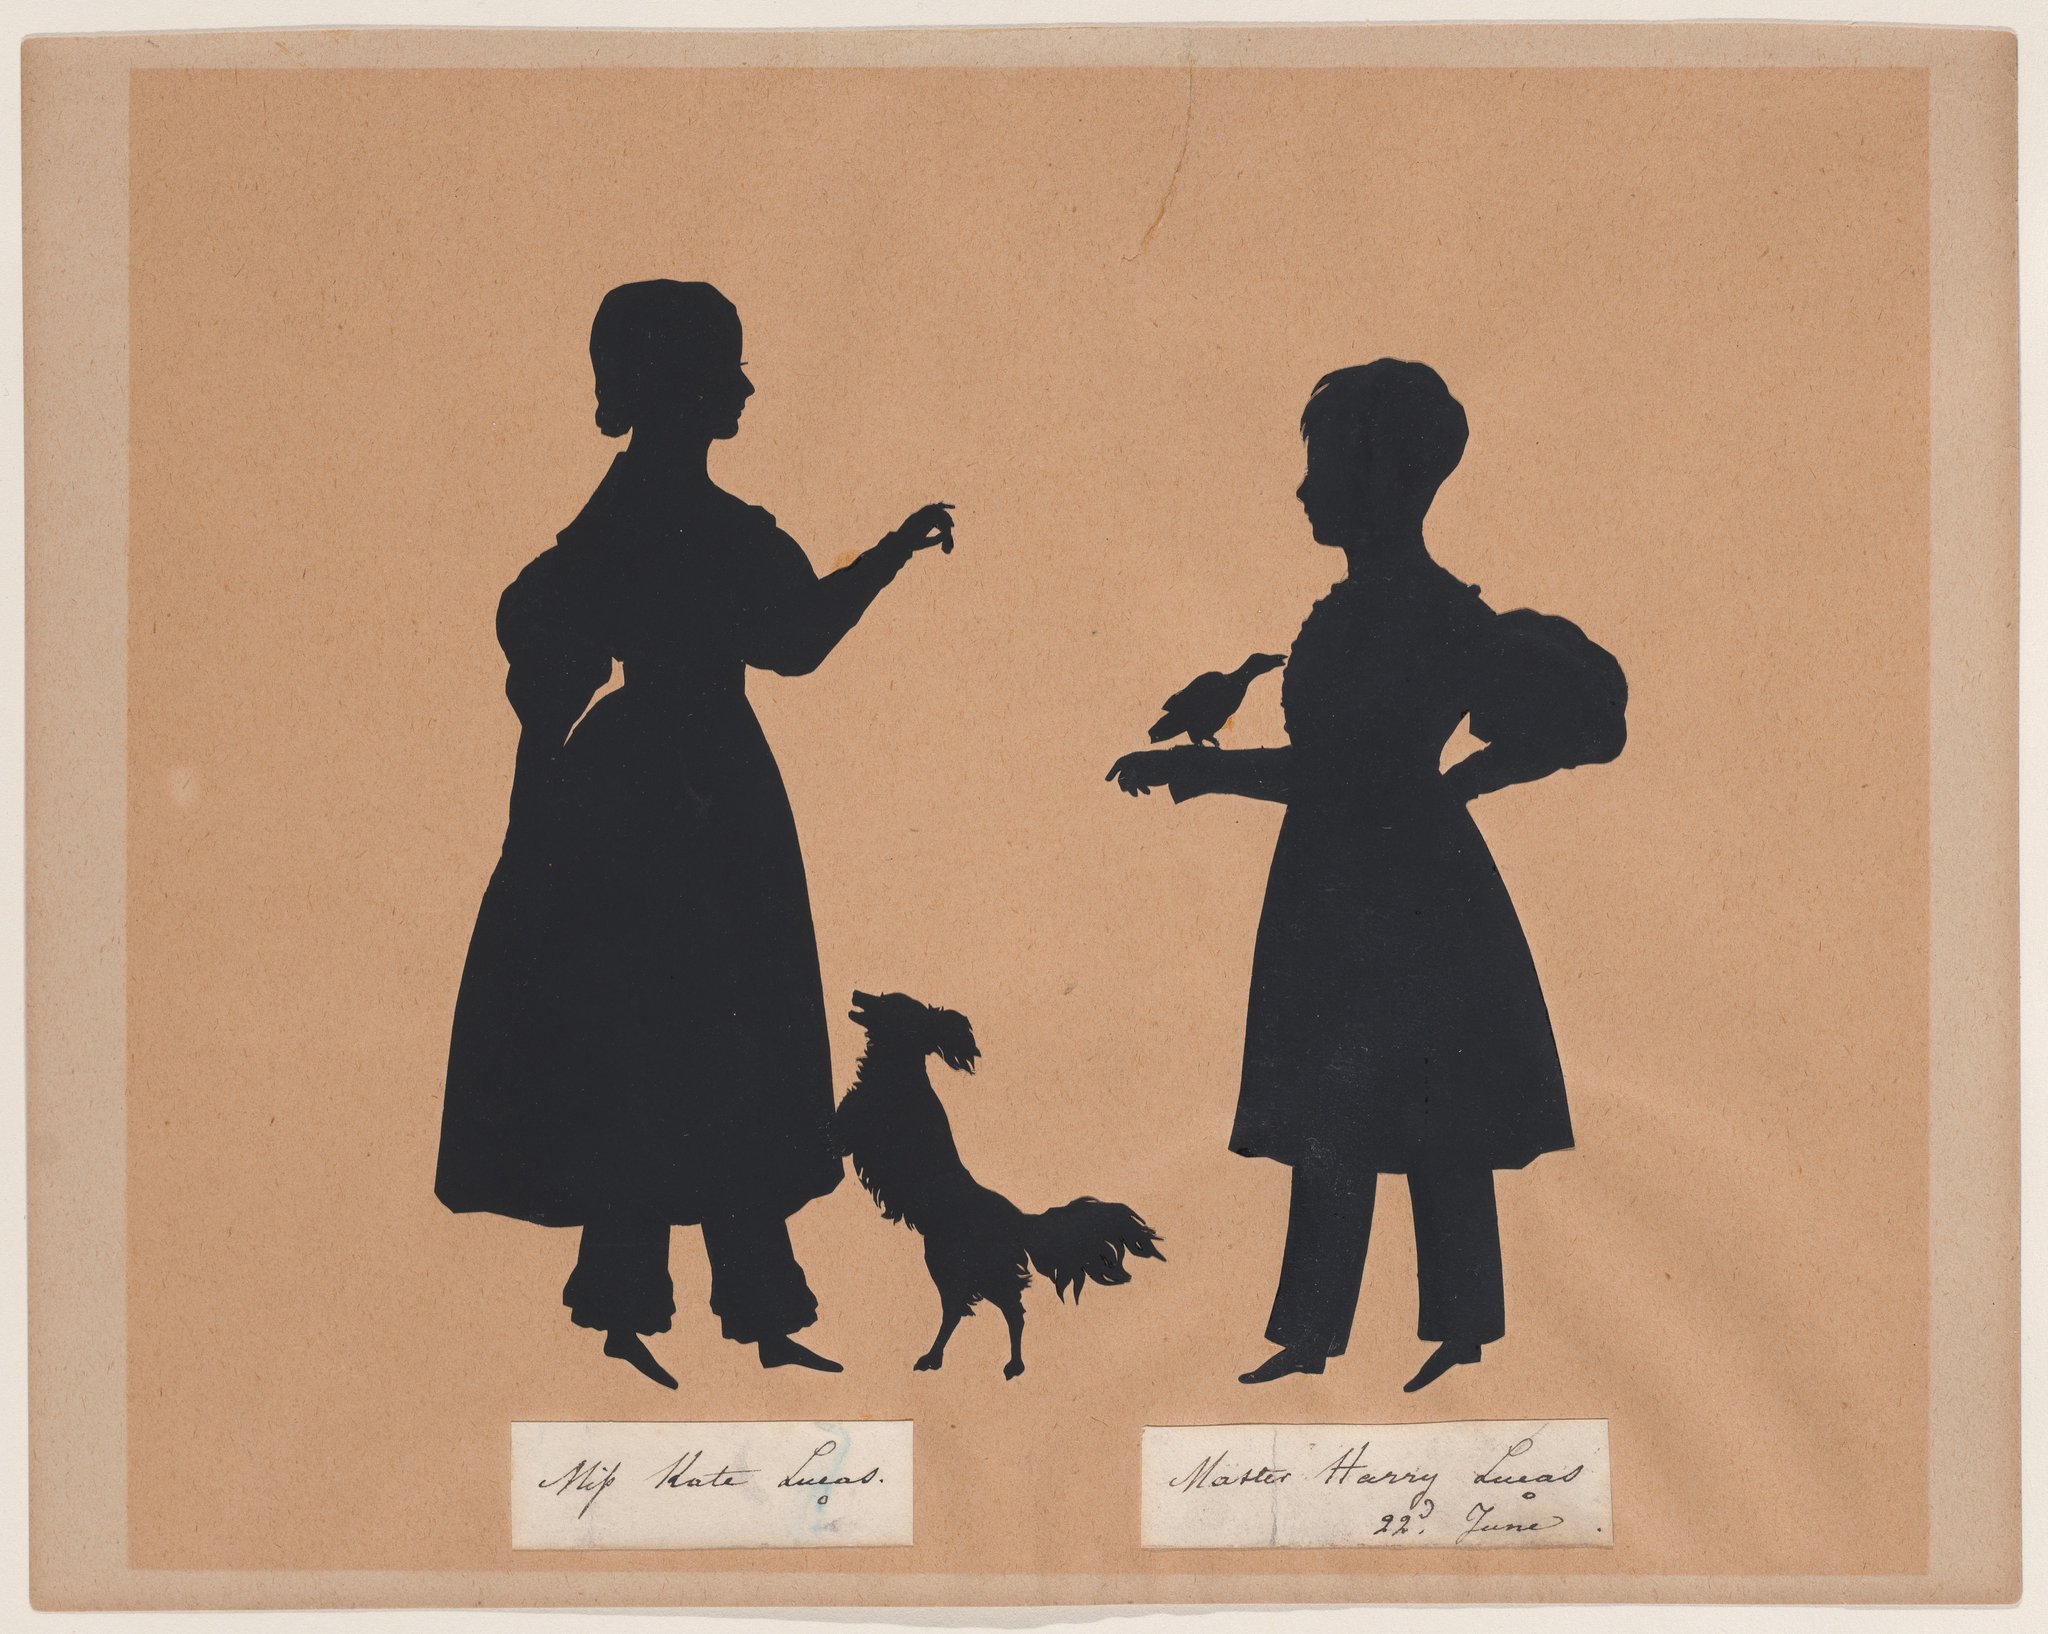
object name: cut paper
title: Kate and Harry Lucas, playing with a dog and a bird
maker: auguste edouart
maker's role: artist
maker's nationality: french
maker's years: 1789-1861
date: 1826-1849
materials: paper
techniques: cutting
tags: birds,boys,girls,dogs